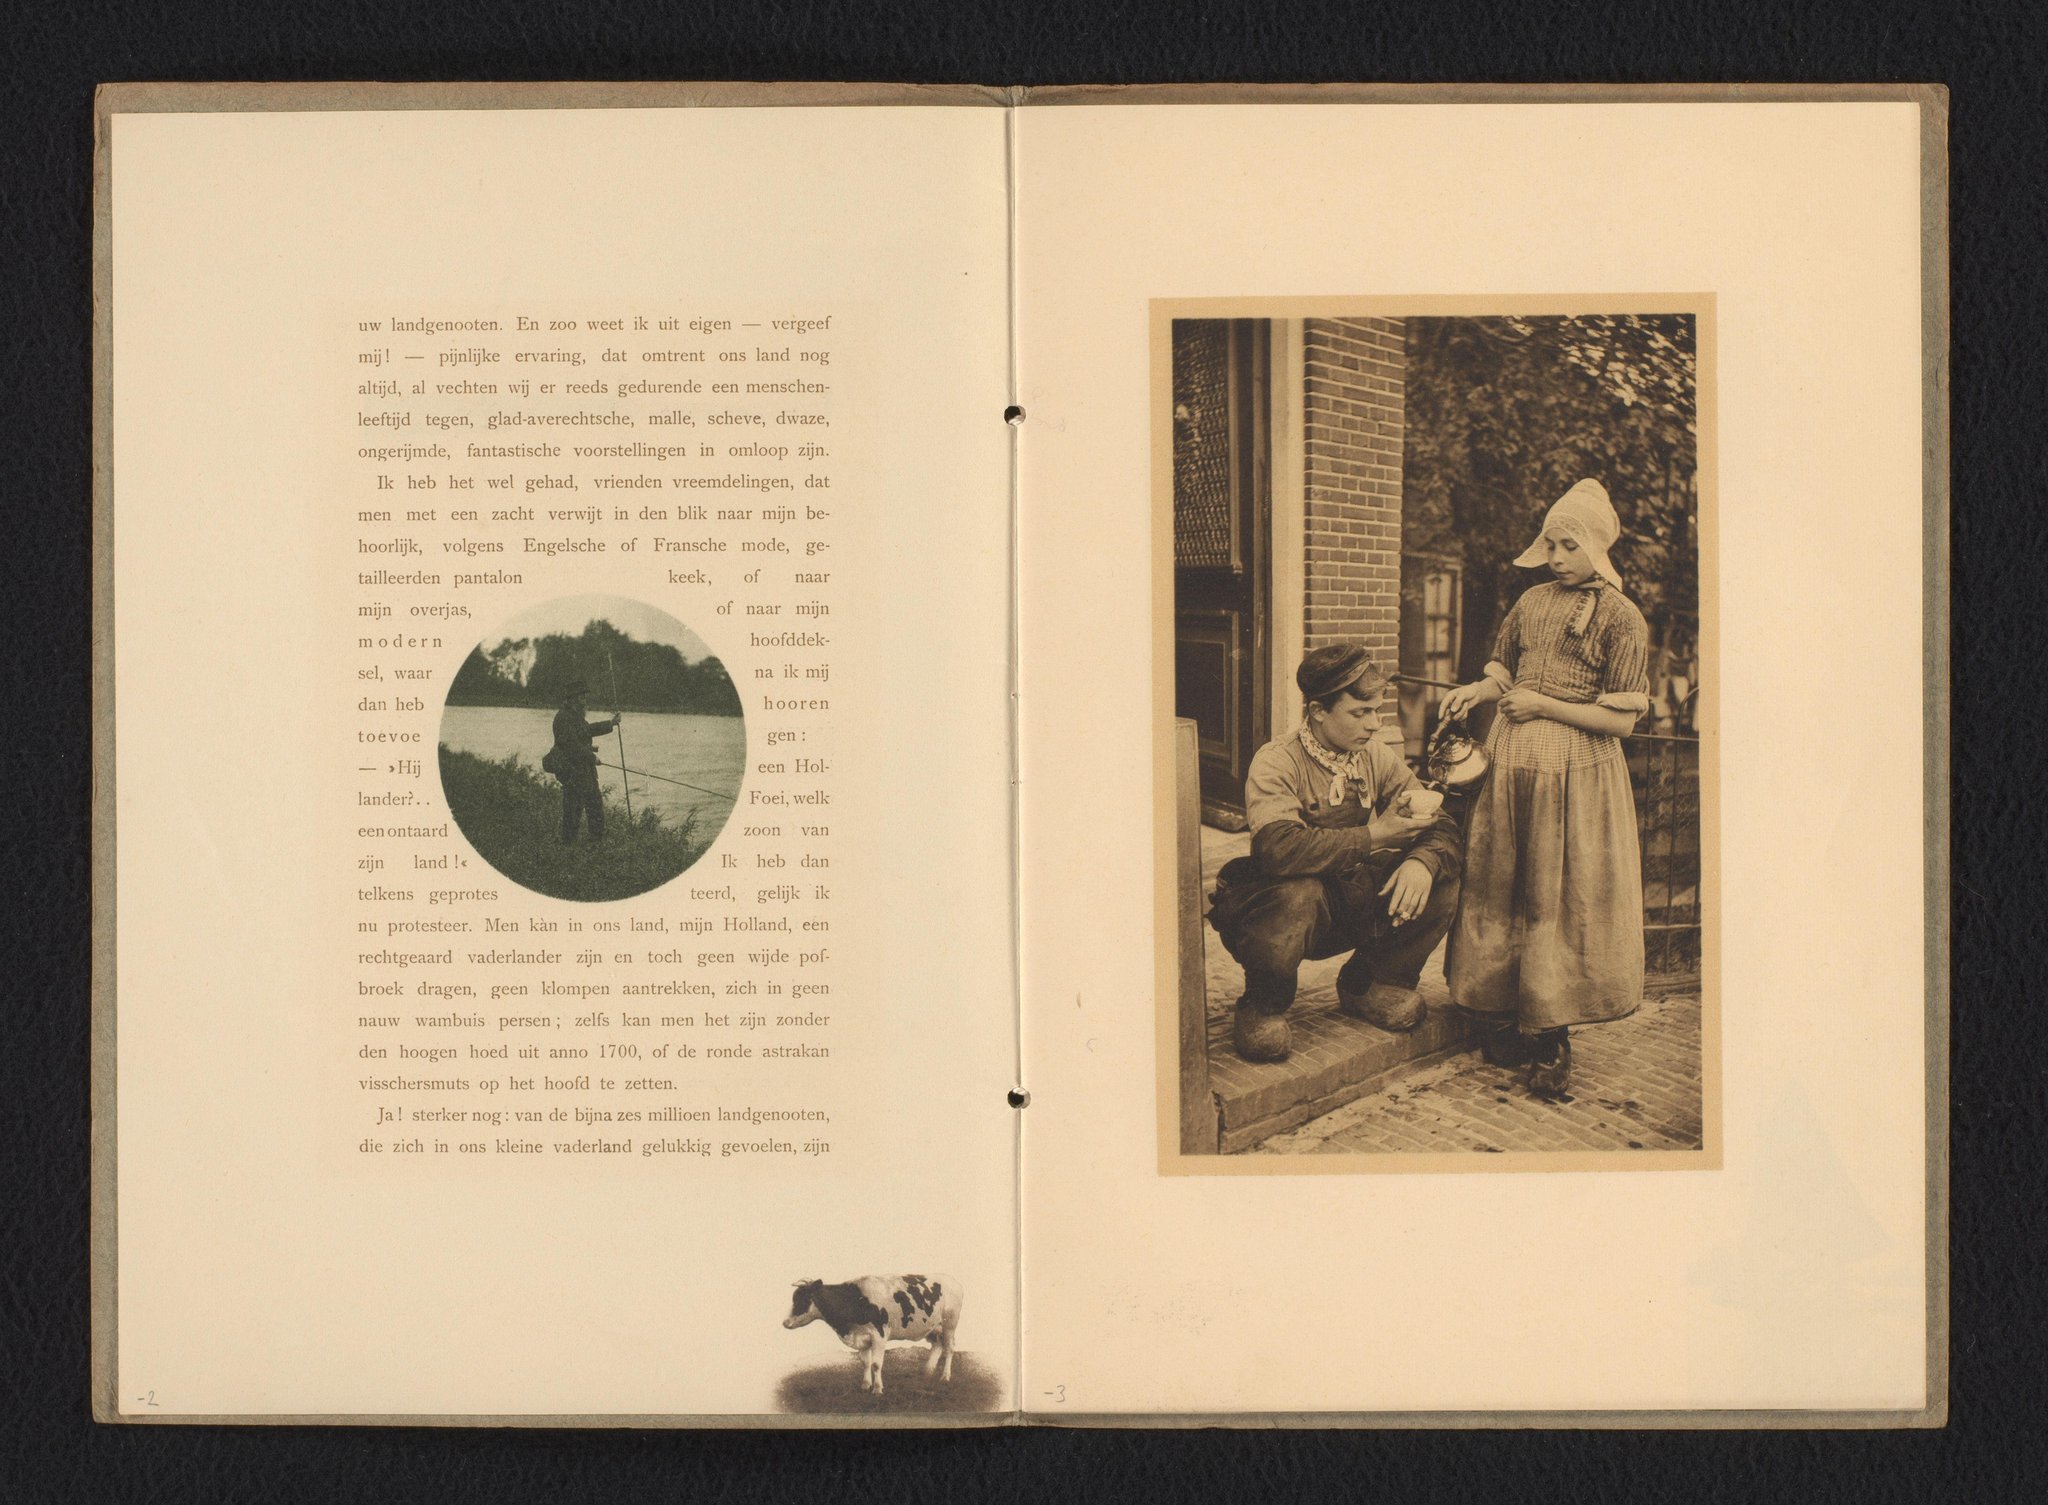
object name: page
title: Meisje serveert een jonge man thee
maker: Anonymous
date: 1905-1910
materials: paper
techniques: photograph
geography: north holland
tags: folk costume, regional costume, cup of tea